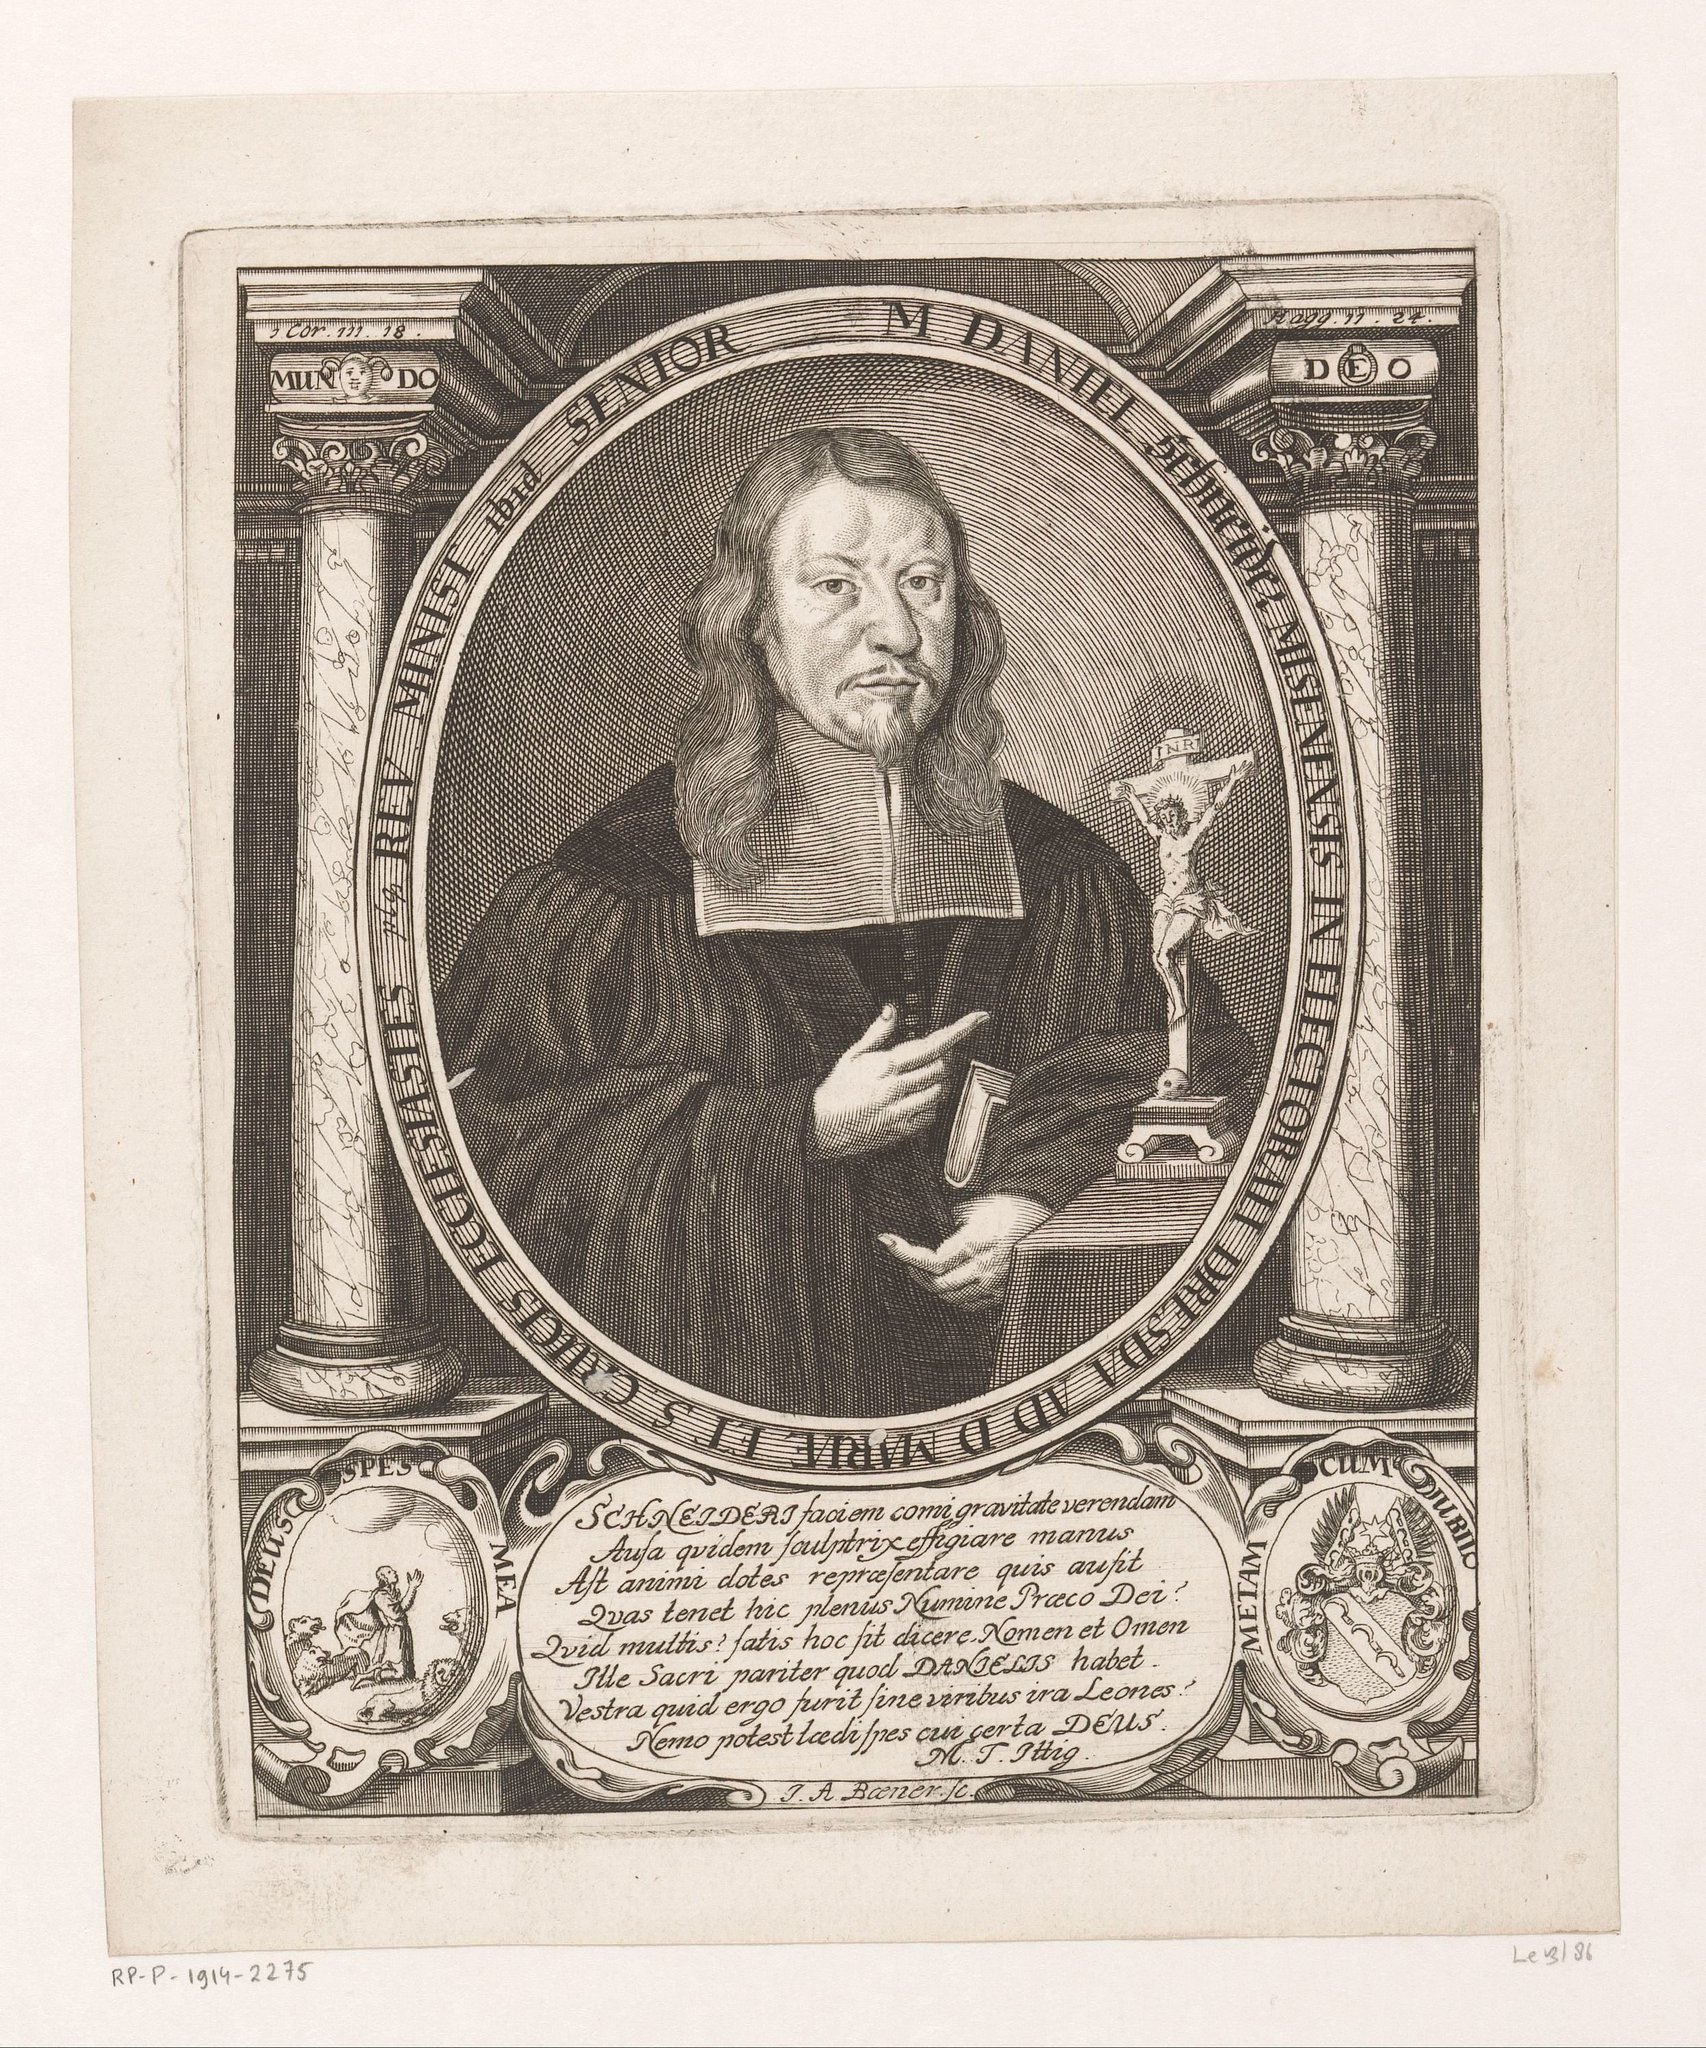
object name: print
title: Portret van Daniel I Schneider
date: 1665-1720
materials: paper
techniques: engraving, etching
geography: nuremberg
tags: historical persons, book, crucifix ~ personal devotion, daniel is thrown into a lion's den ~ king cyrus, armorial bearing, heraldry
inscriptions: collector's mark: Lugt 2228